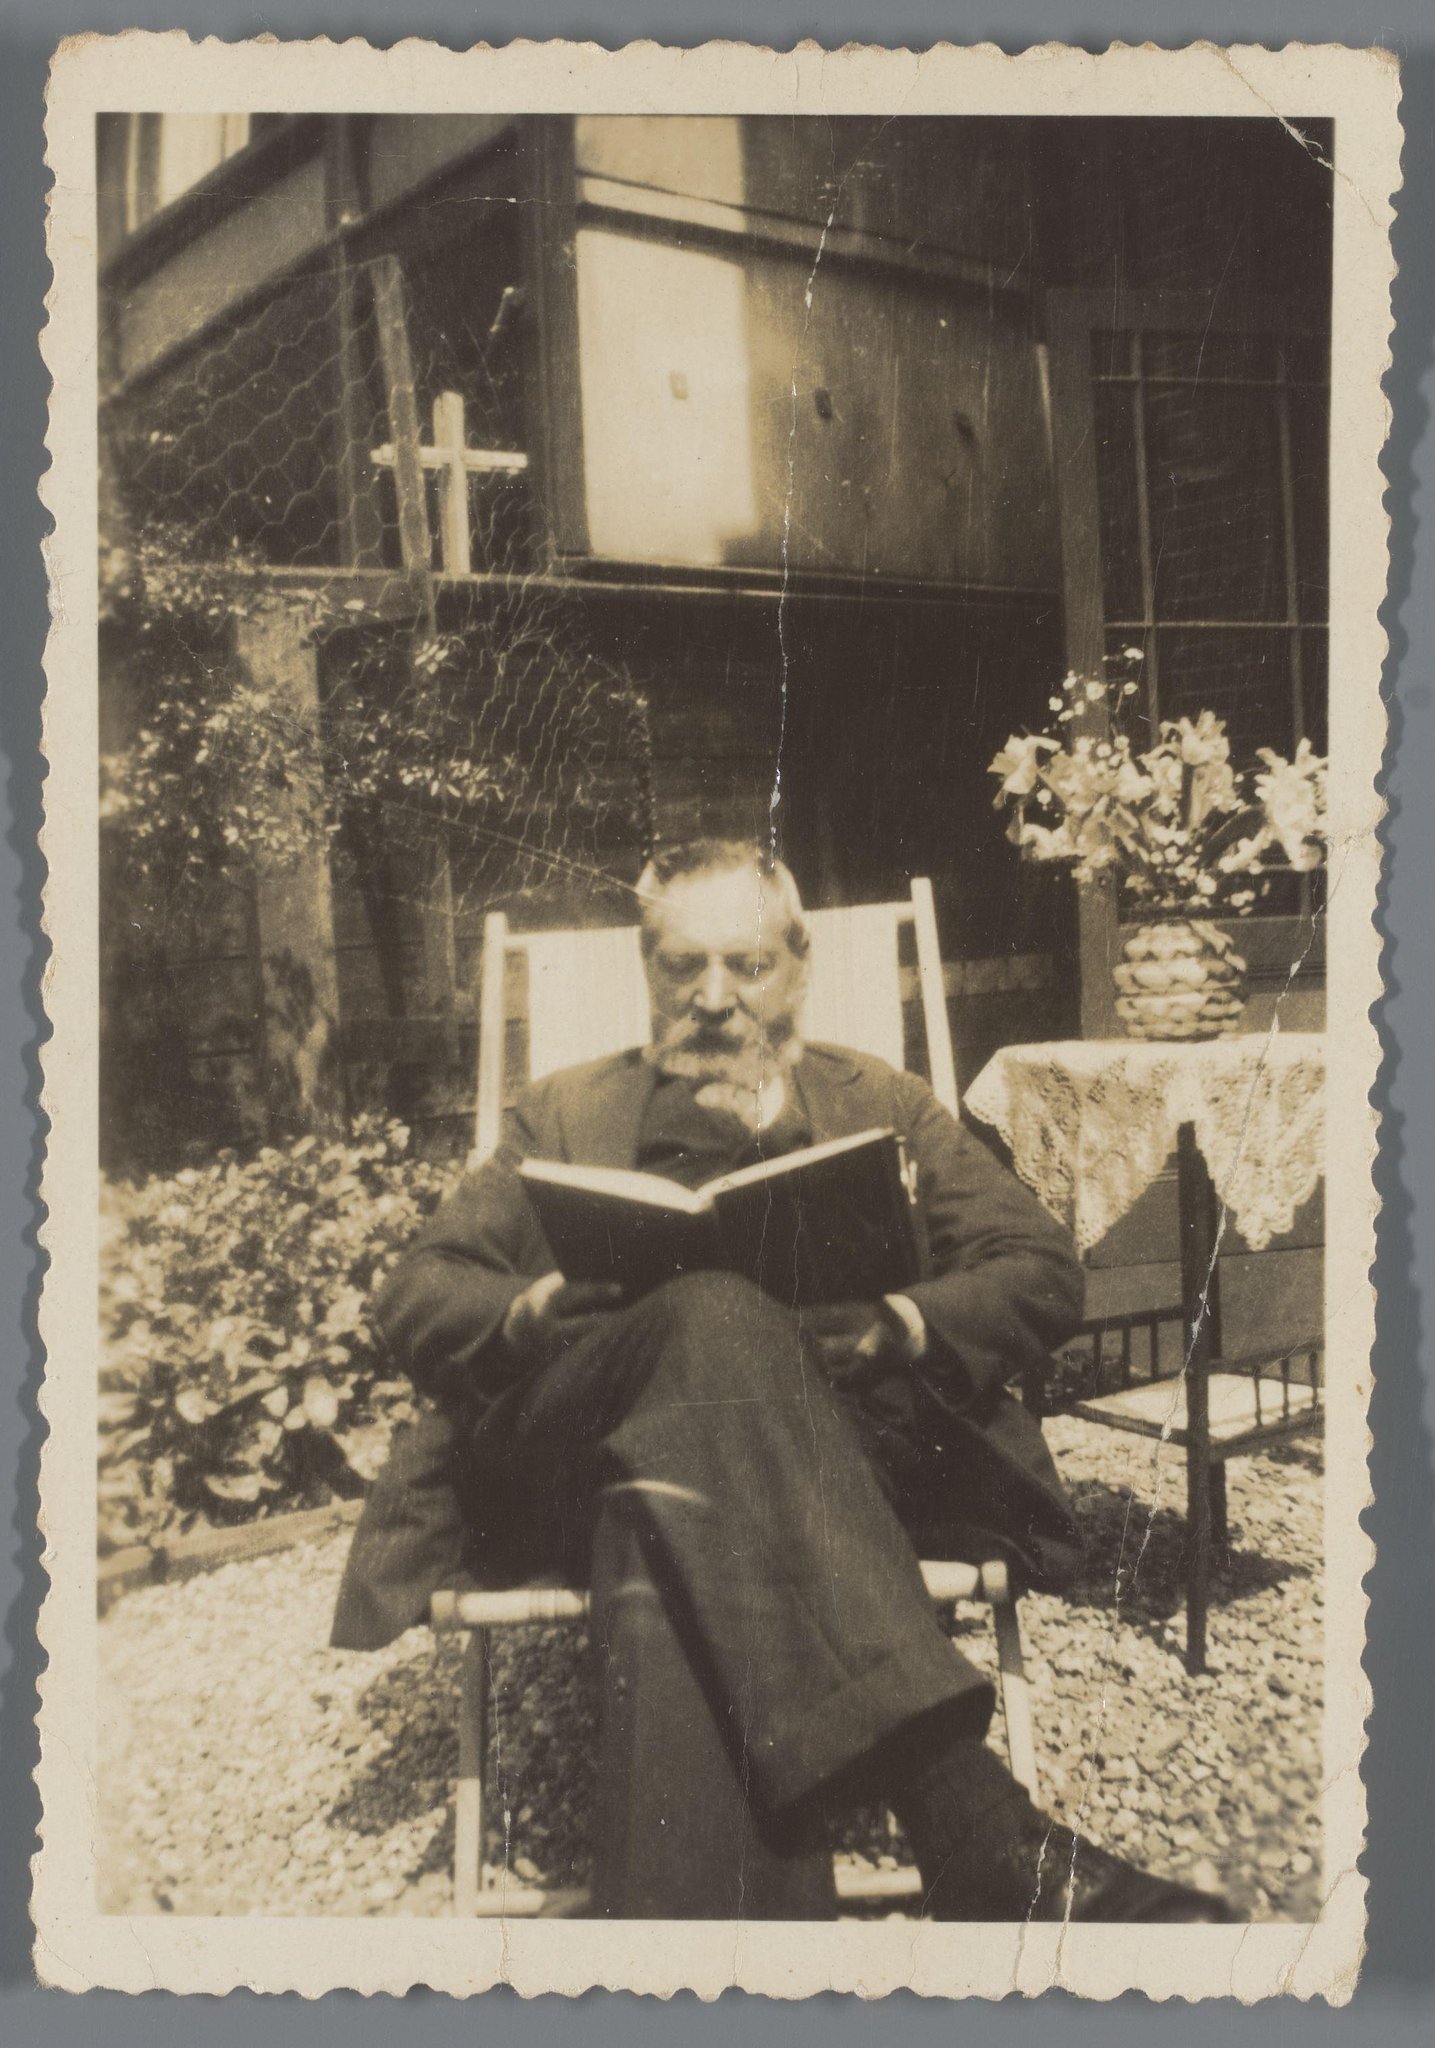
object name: photograph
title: Portret van een onbekende man, lezend in de tuin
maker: Anonymous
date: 1890-1910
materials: photographic support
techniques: gelatin silver print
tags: sitting figure (+ front view), reading, garden, historical persons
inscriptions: annotation: ‘[...]’, factory mark: ‘velox’